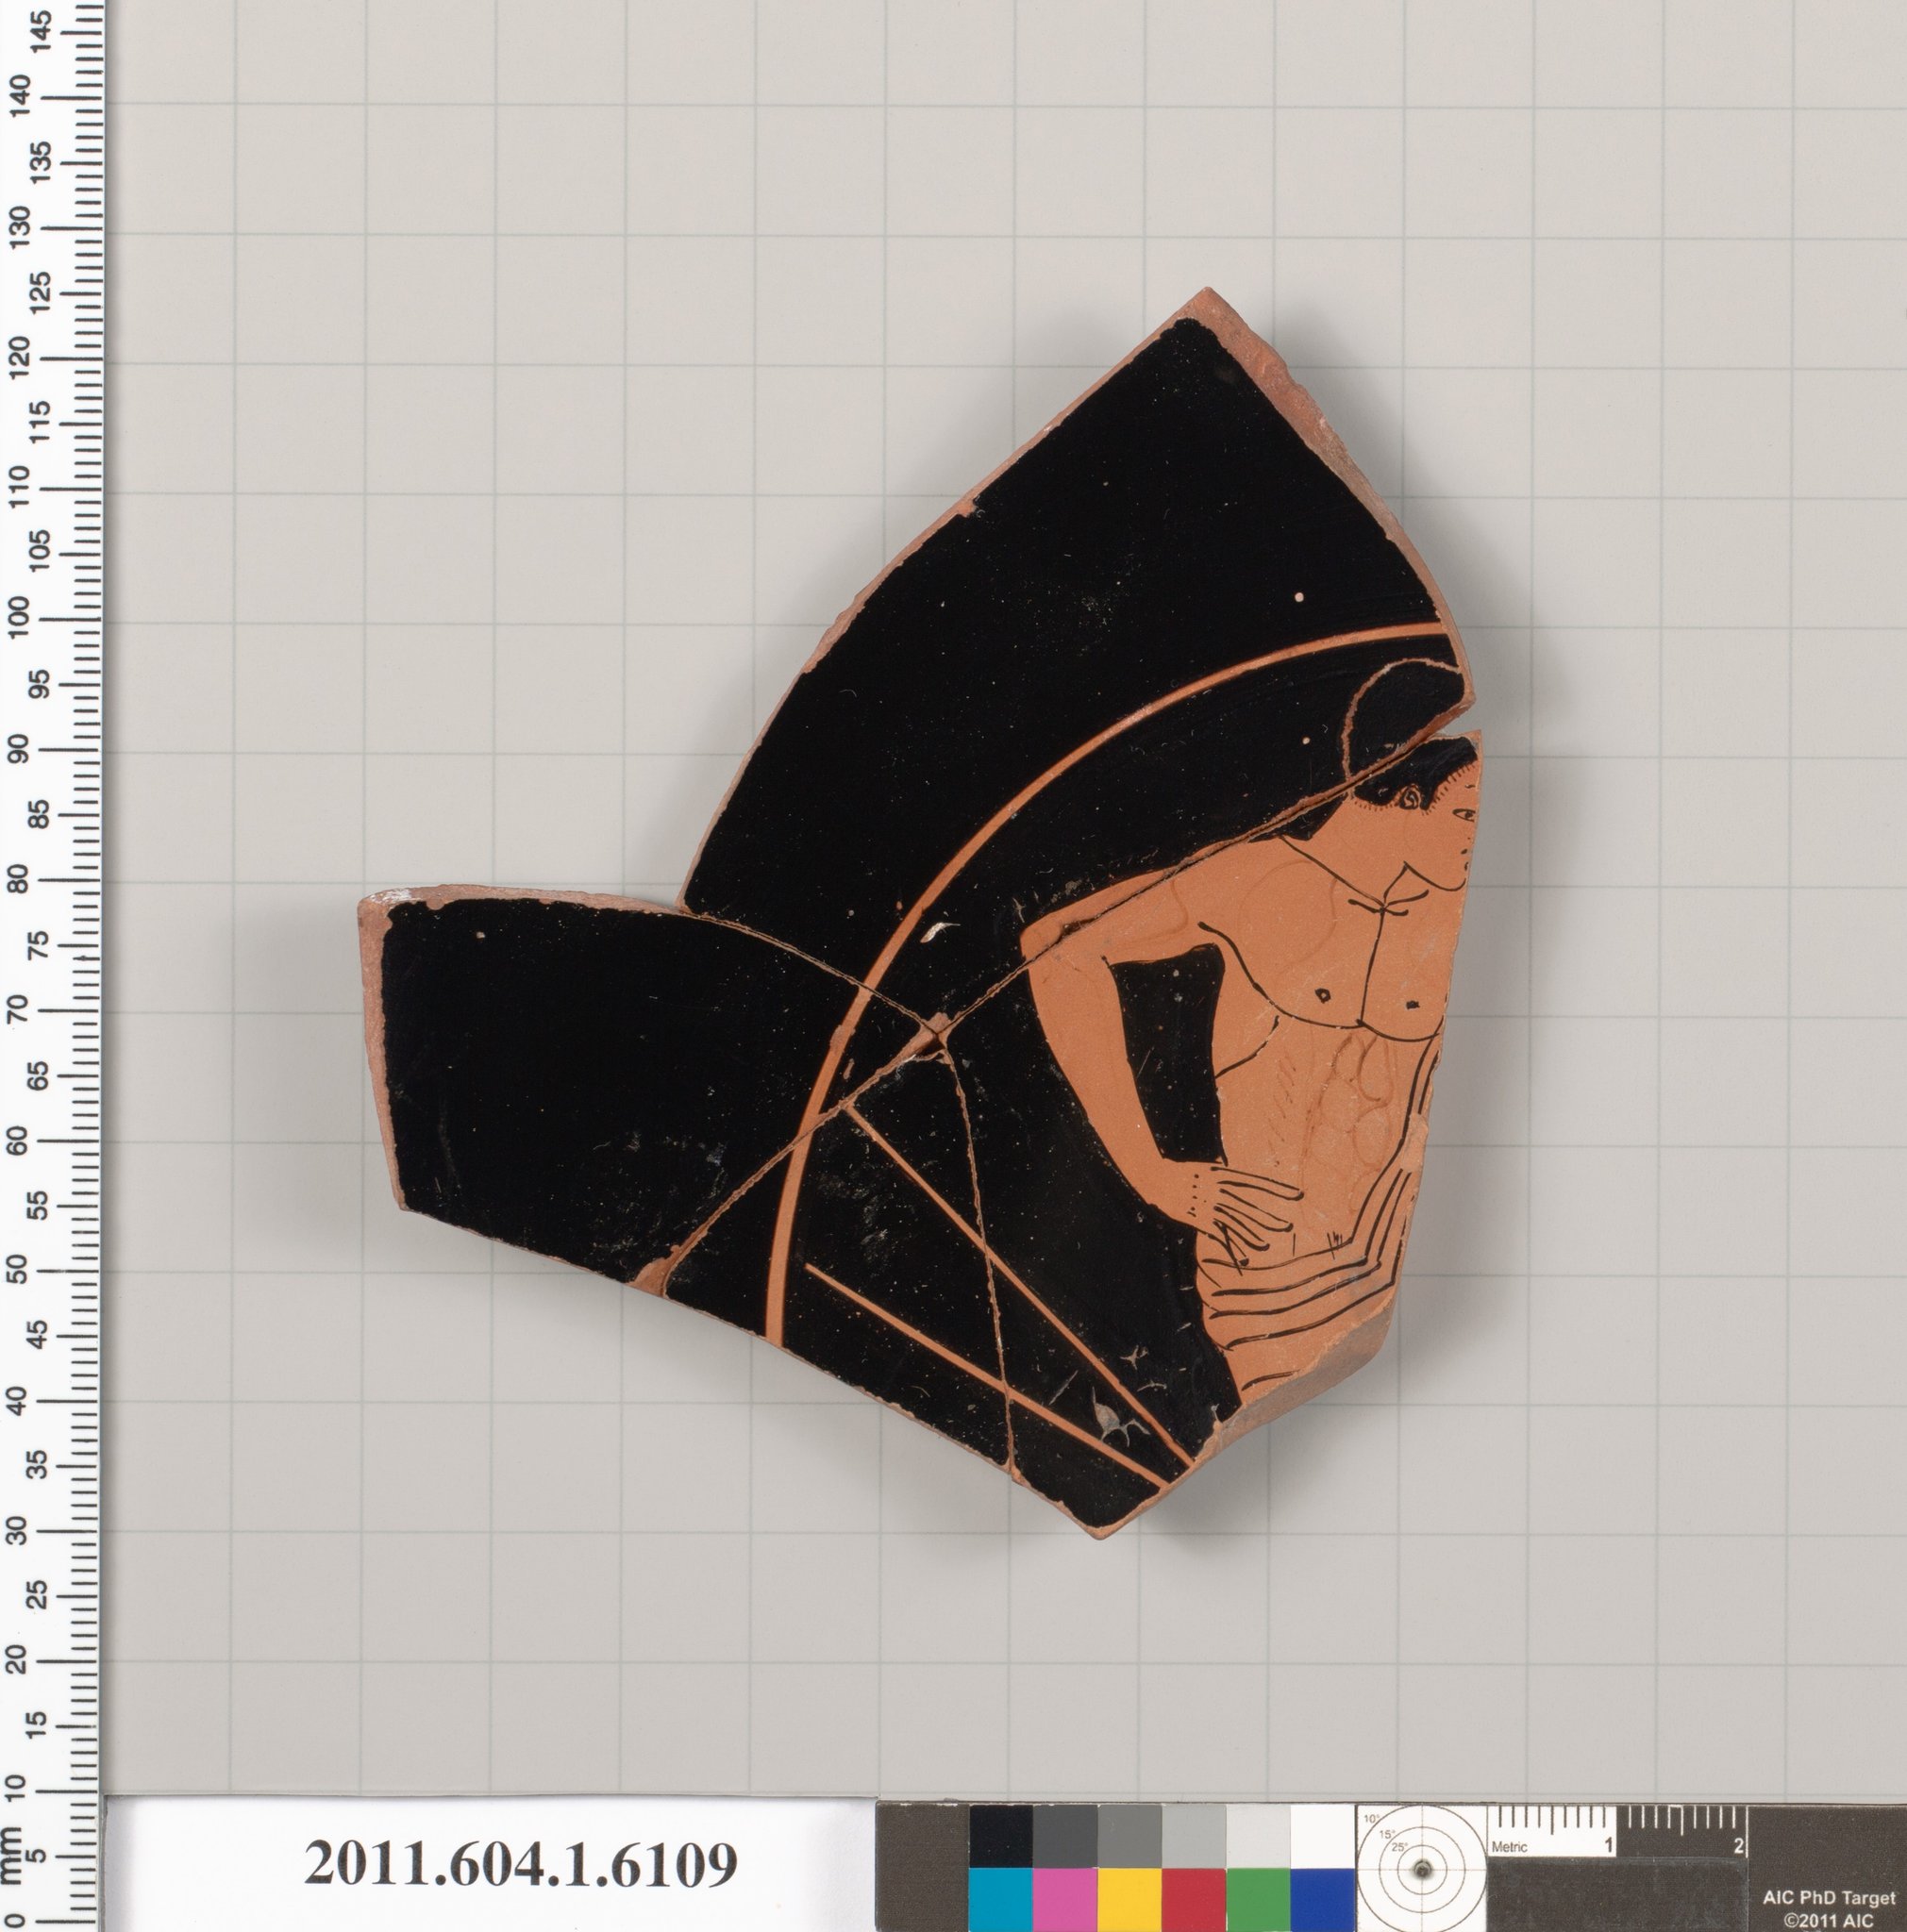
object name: kylix fragment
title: Terracotta fragment of a kylix (drinking cup)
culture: greek, attic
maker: elpinikos painter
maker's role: artist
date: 520-500 BCE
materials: terracotta